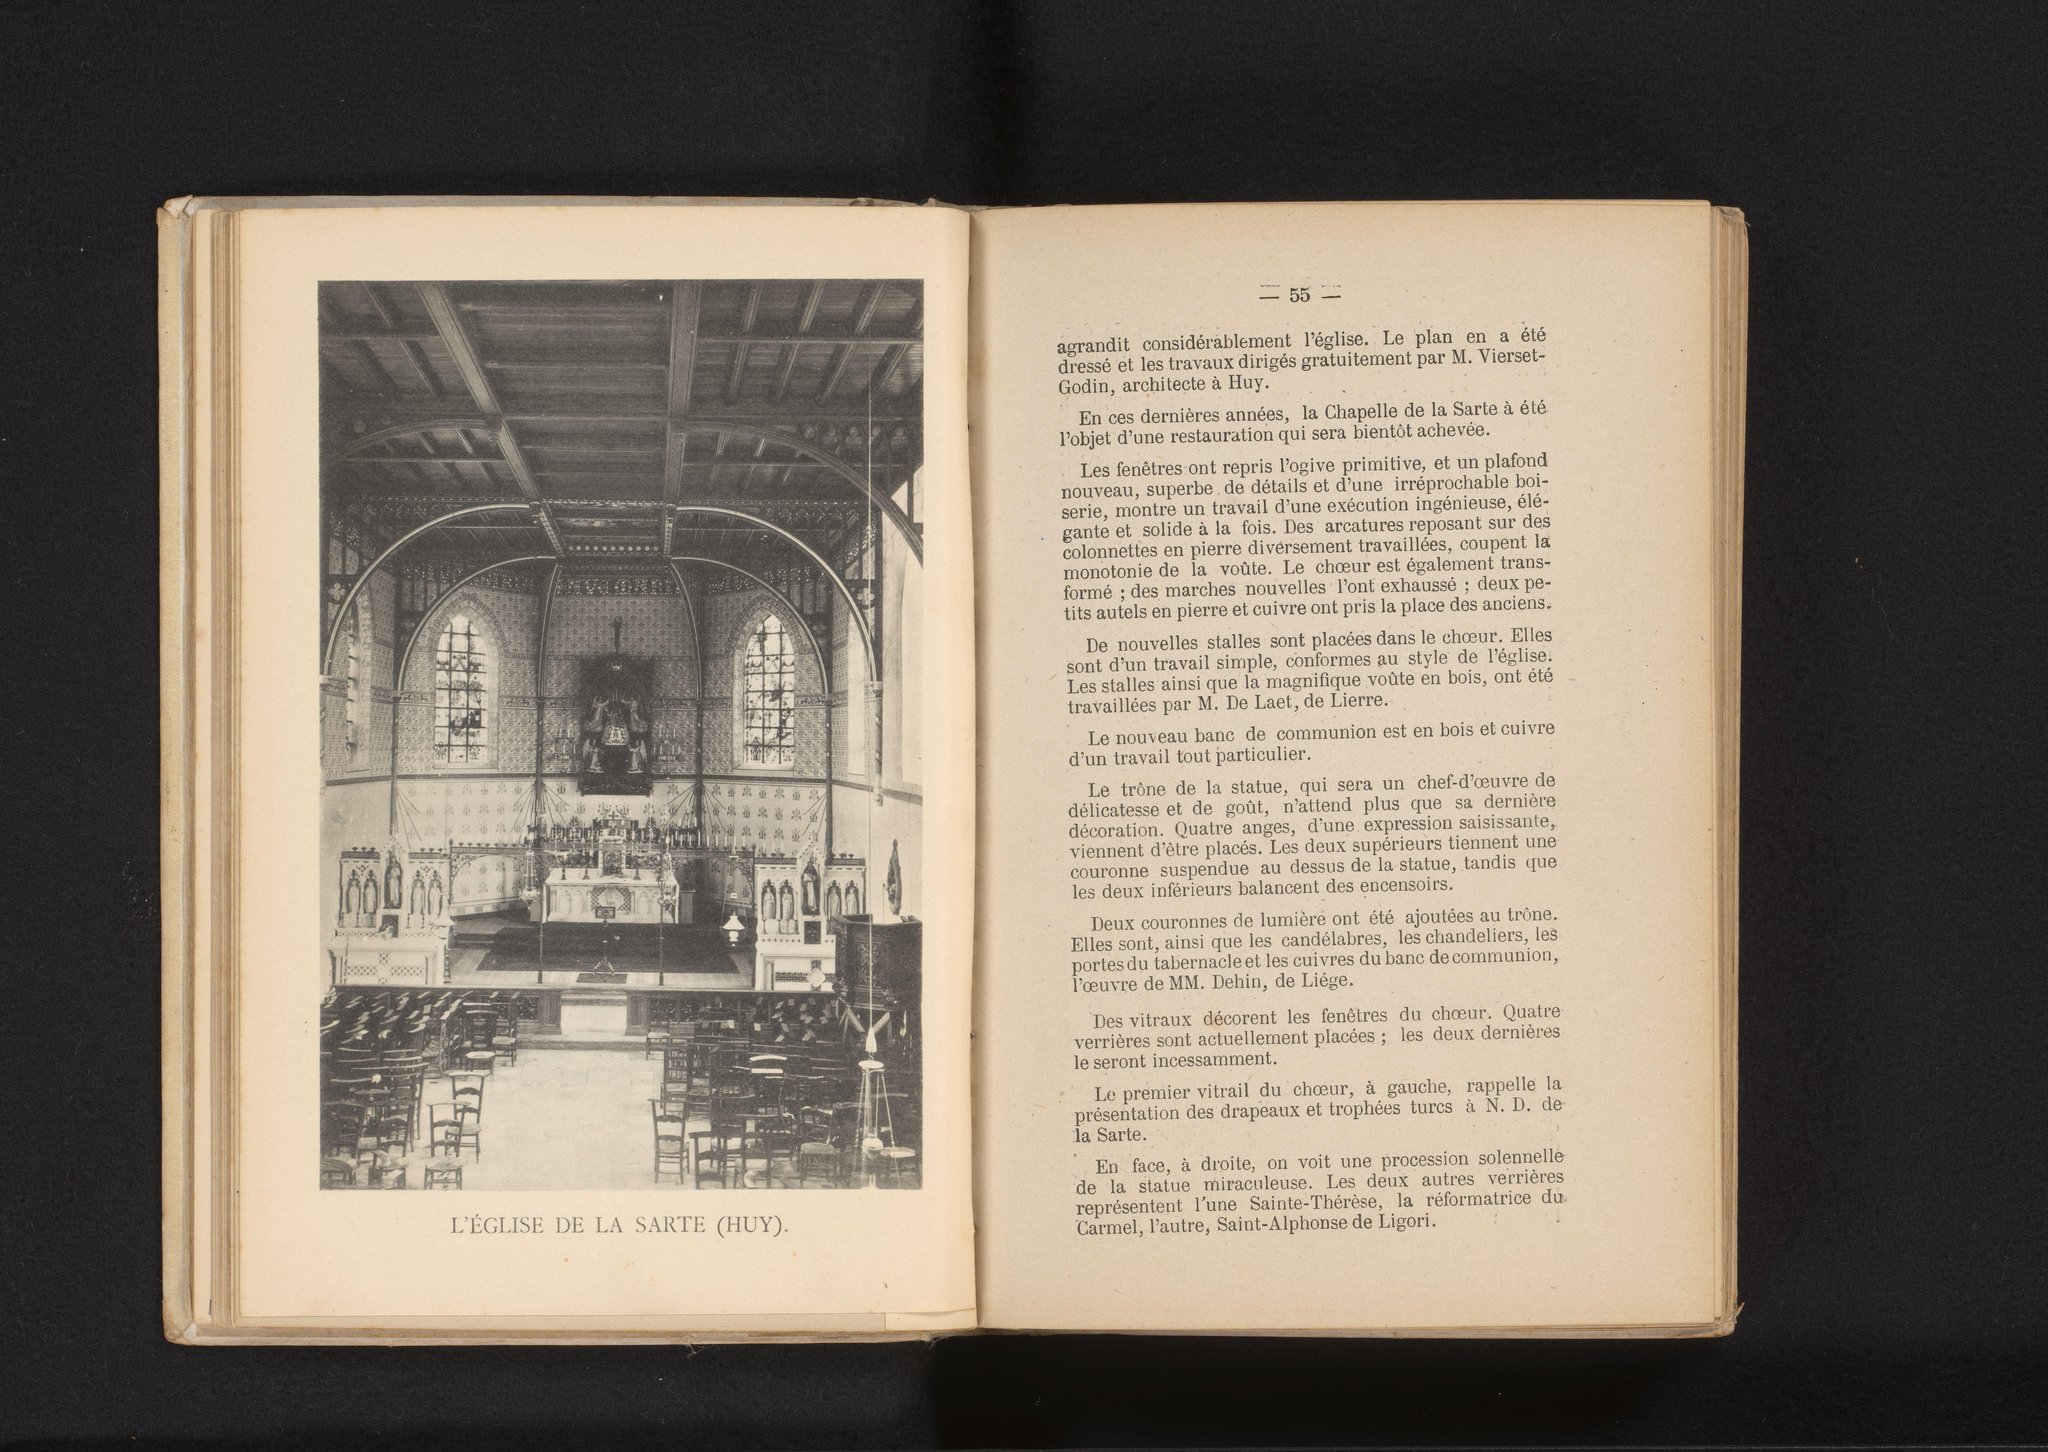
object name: photomechanical print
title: Interieur van de Église Notre-Dame de la Sarte te Hoei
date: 1885-1890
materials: paper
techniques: photograph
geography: hoei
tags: interior of church